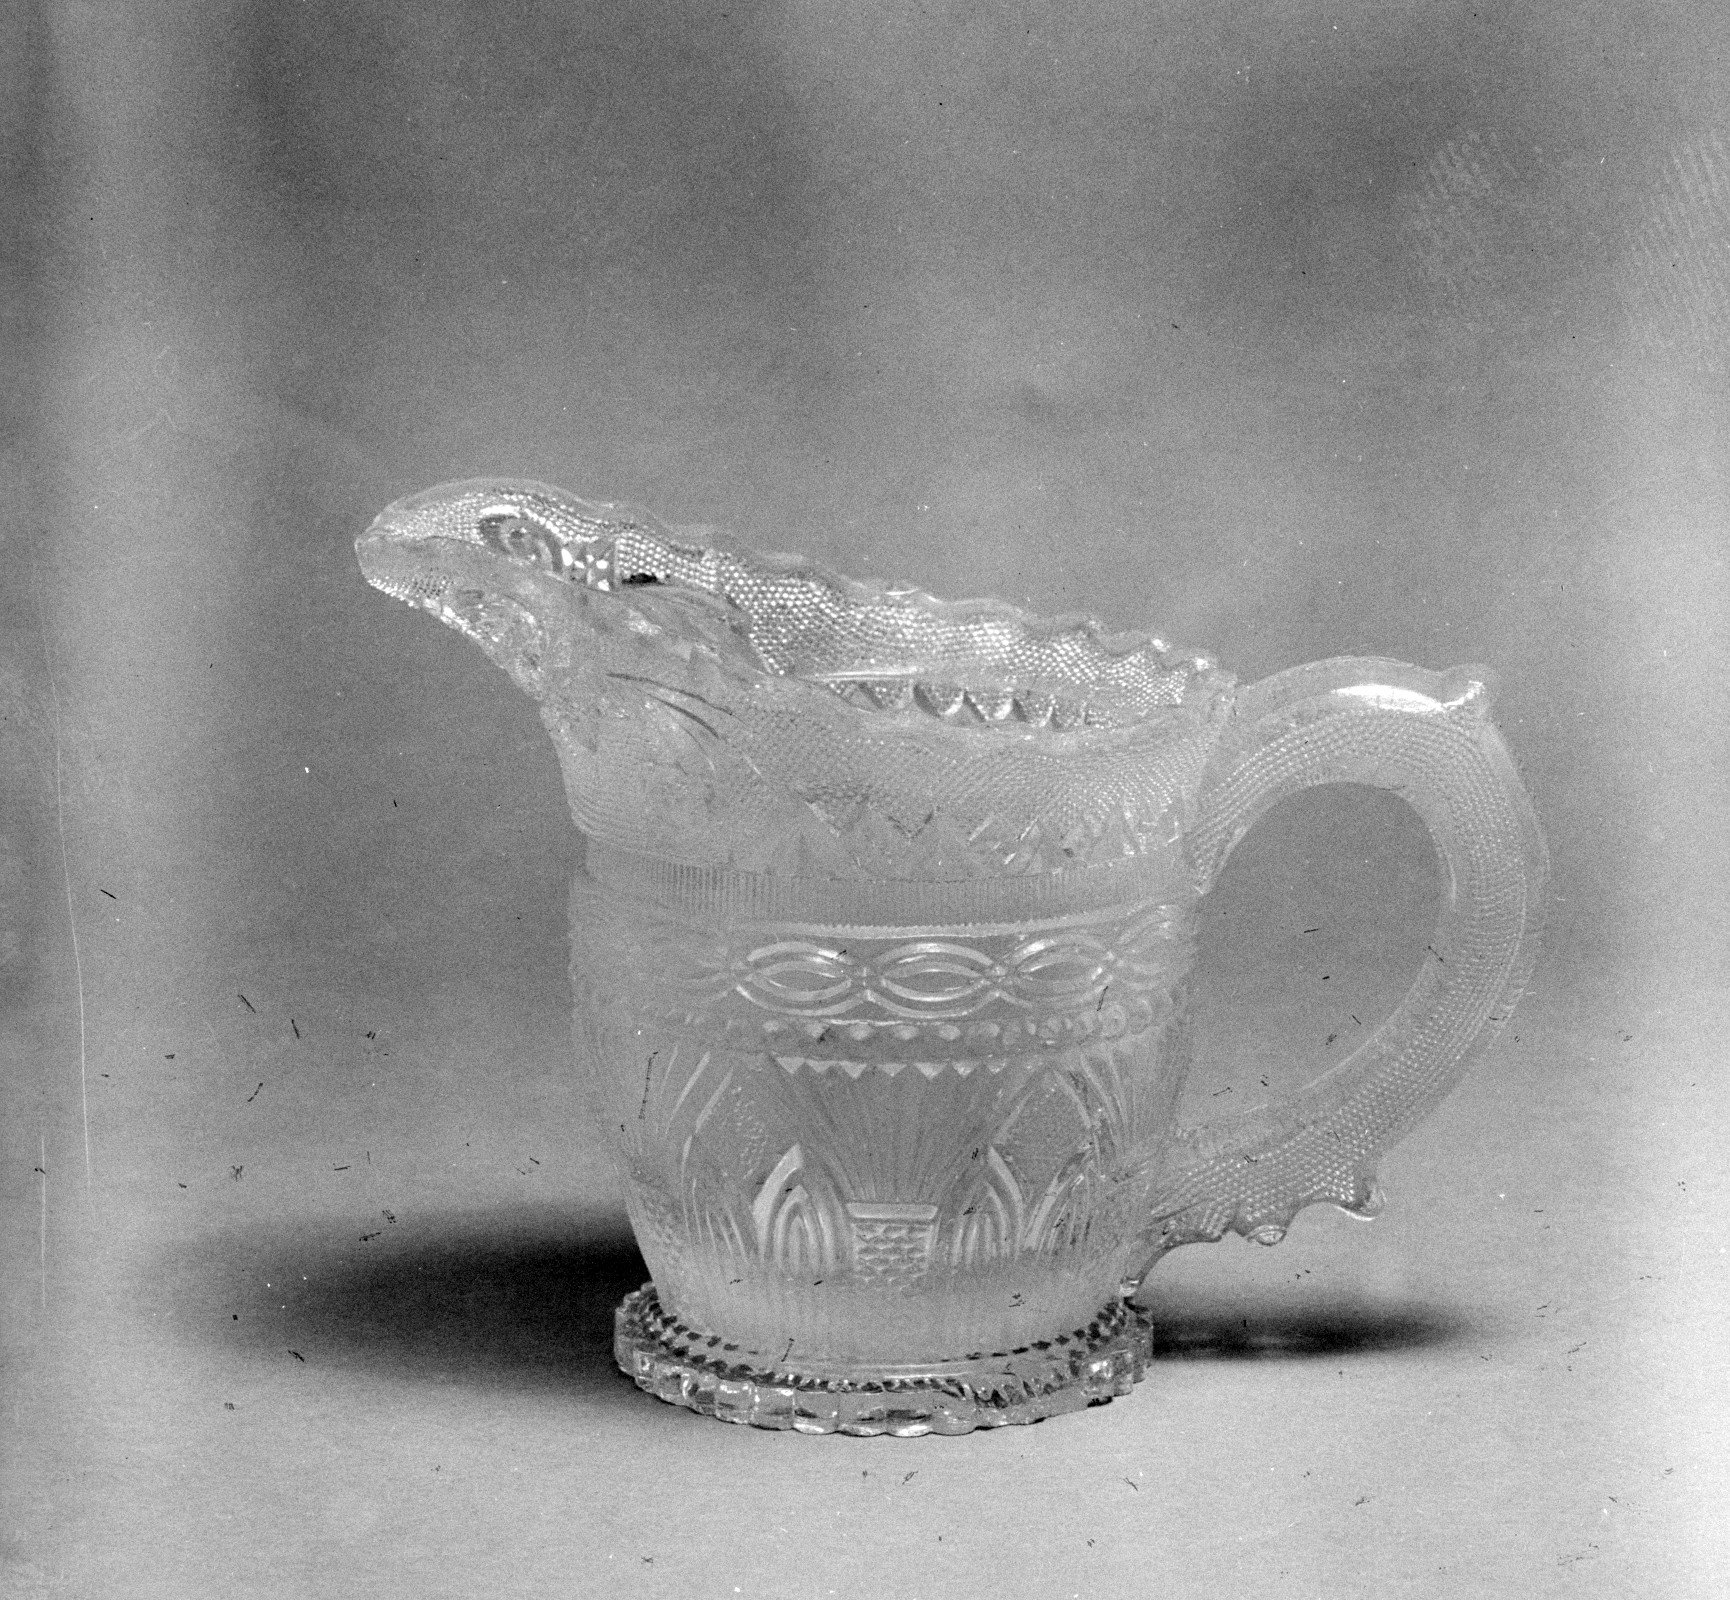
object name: cream pot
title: Creamer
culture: american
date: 1830-1840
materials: glass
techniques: pressed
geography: united states